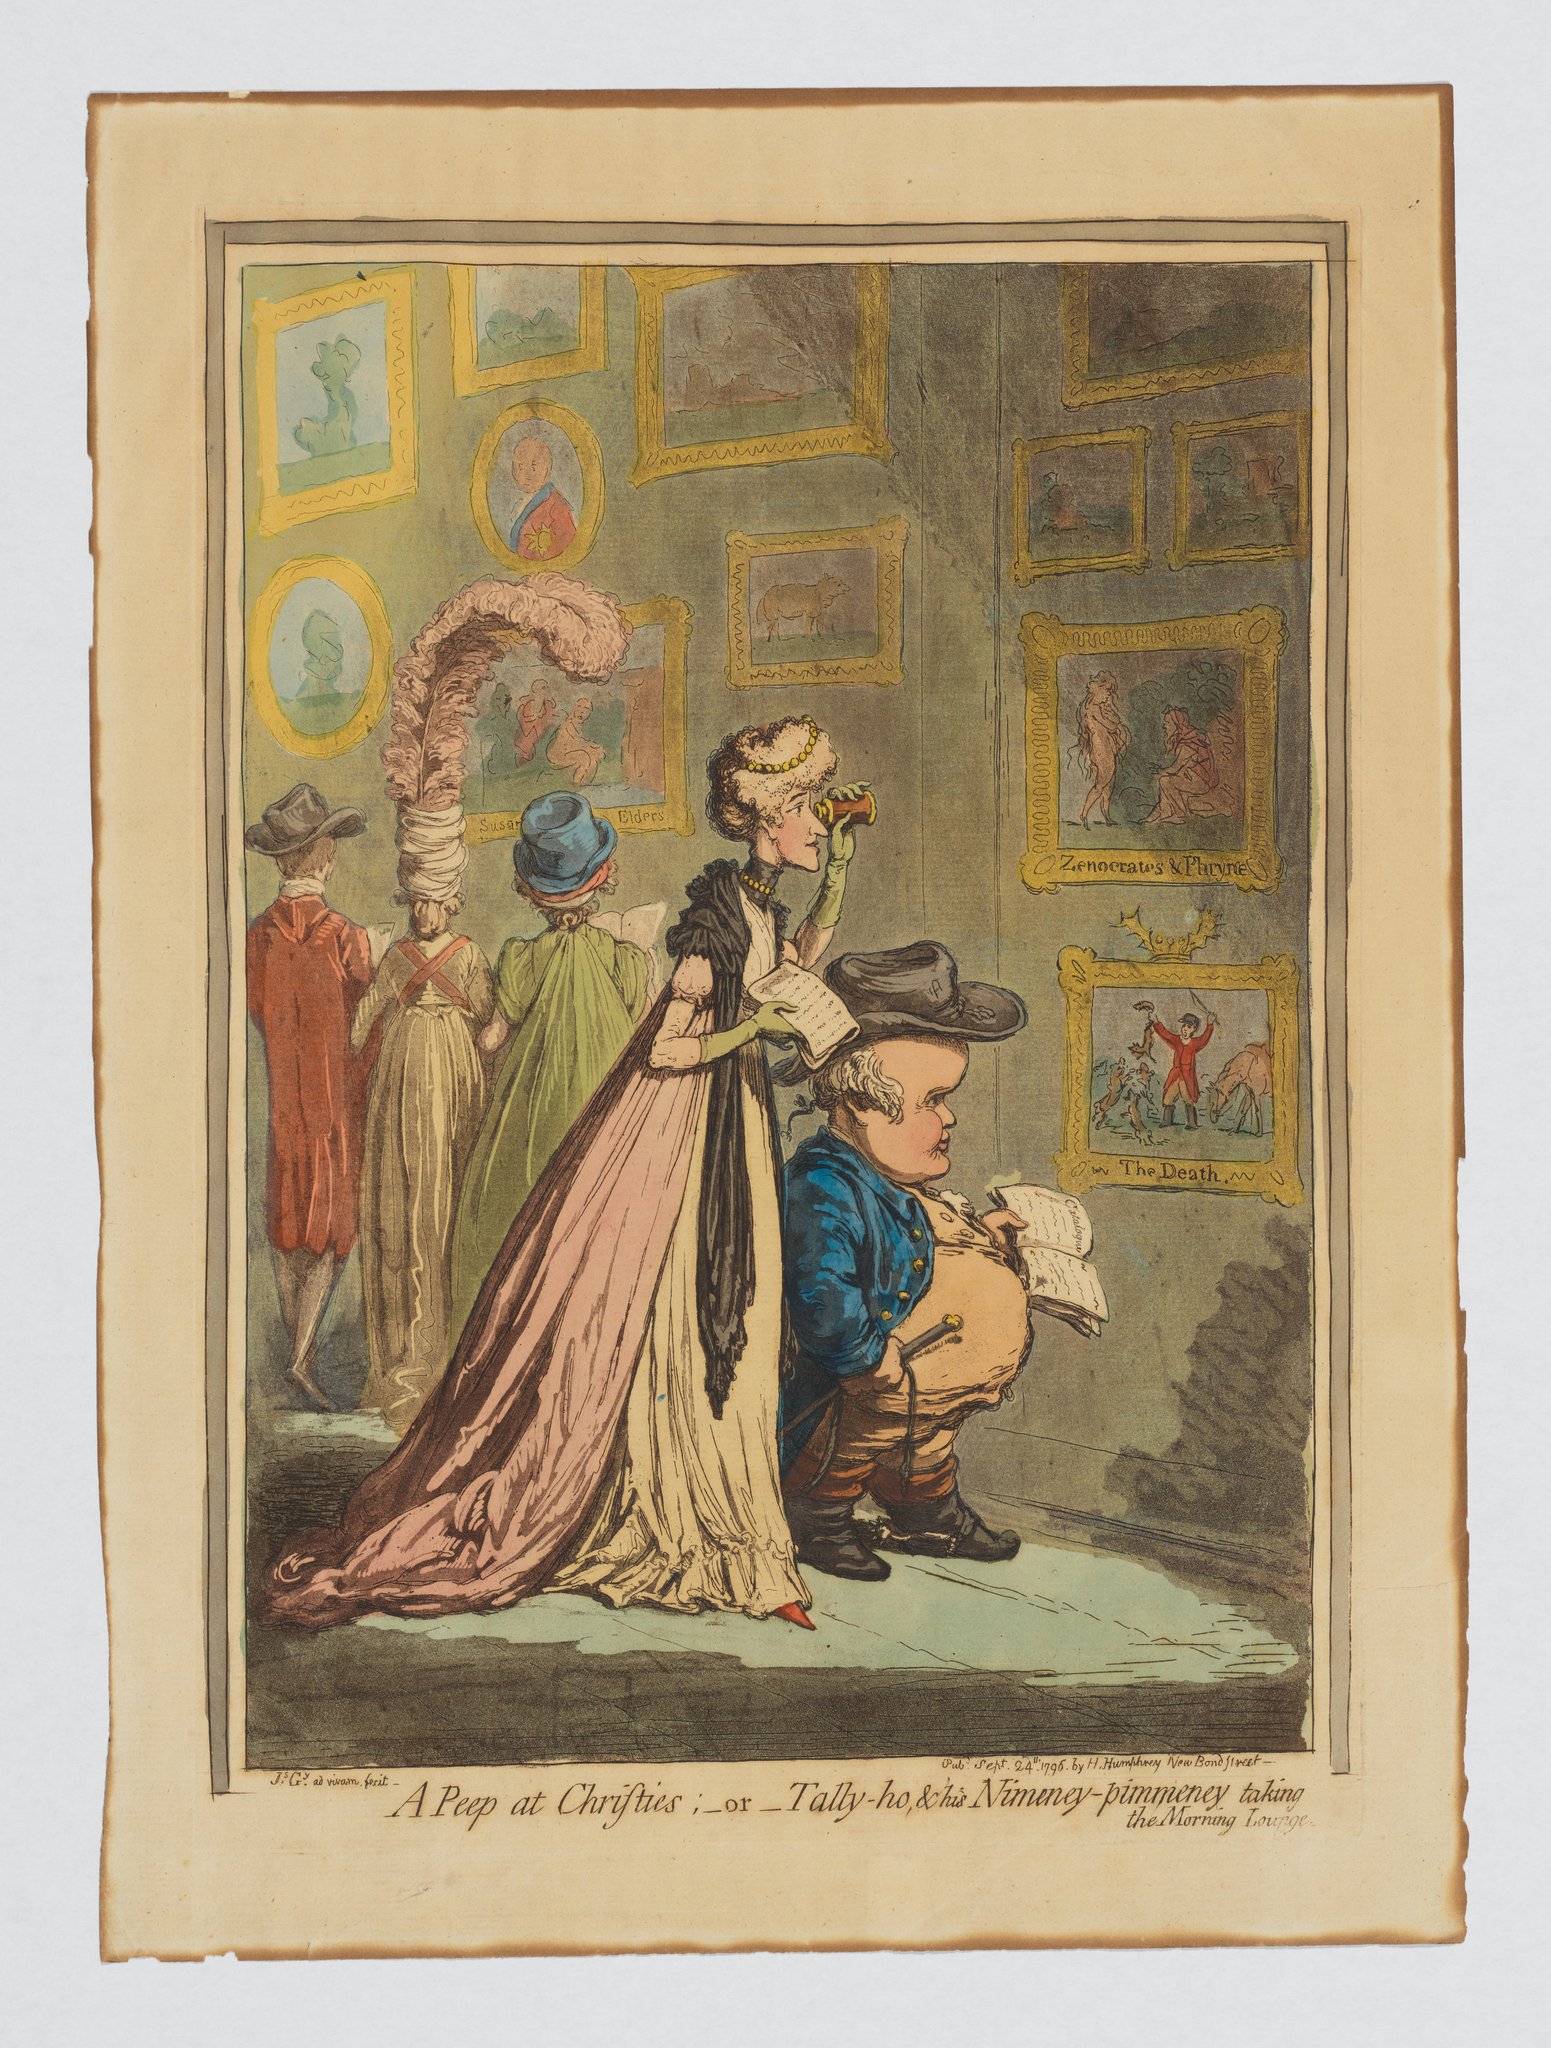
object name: print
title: A Peep at Christies;–or–Tally-ho & his Nimeny-pimeney taking the Morning Lounge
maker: james gillray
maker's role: artist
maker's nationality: british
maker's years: 1756-1815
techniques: aquatint, etching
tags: painting,satire,men,women